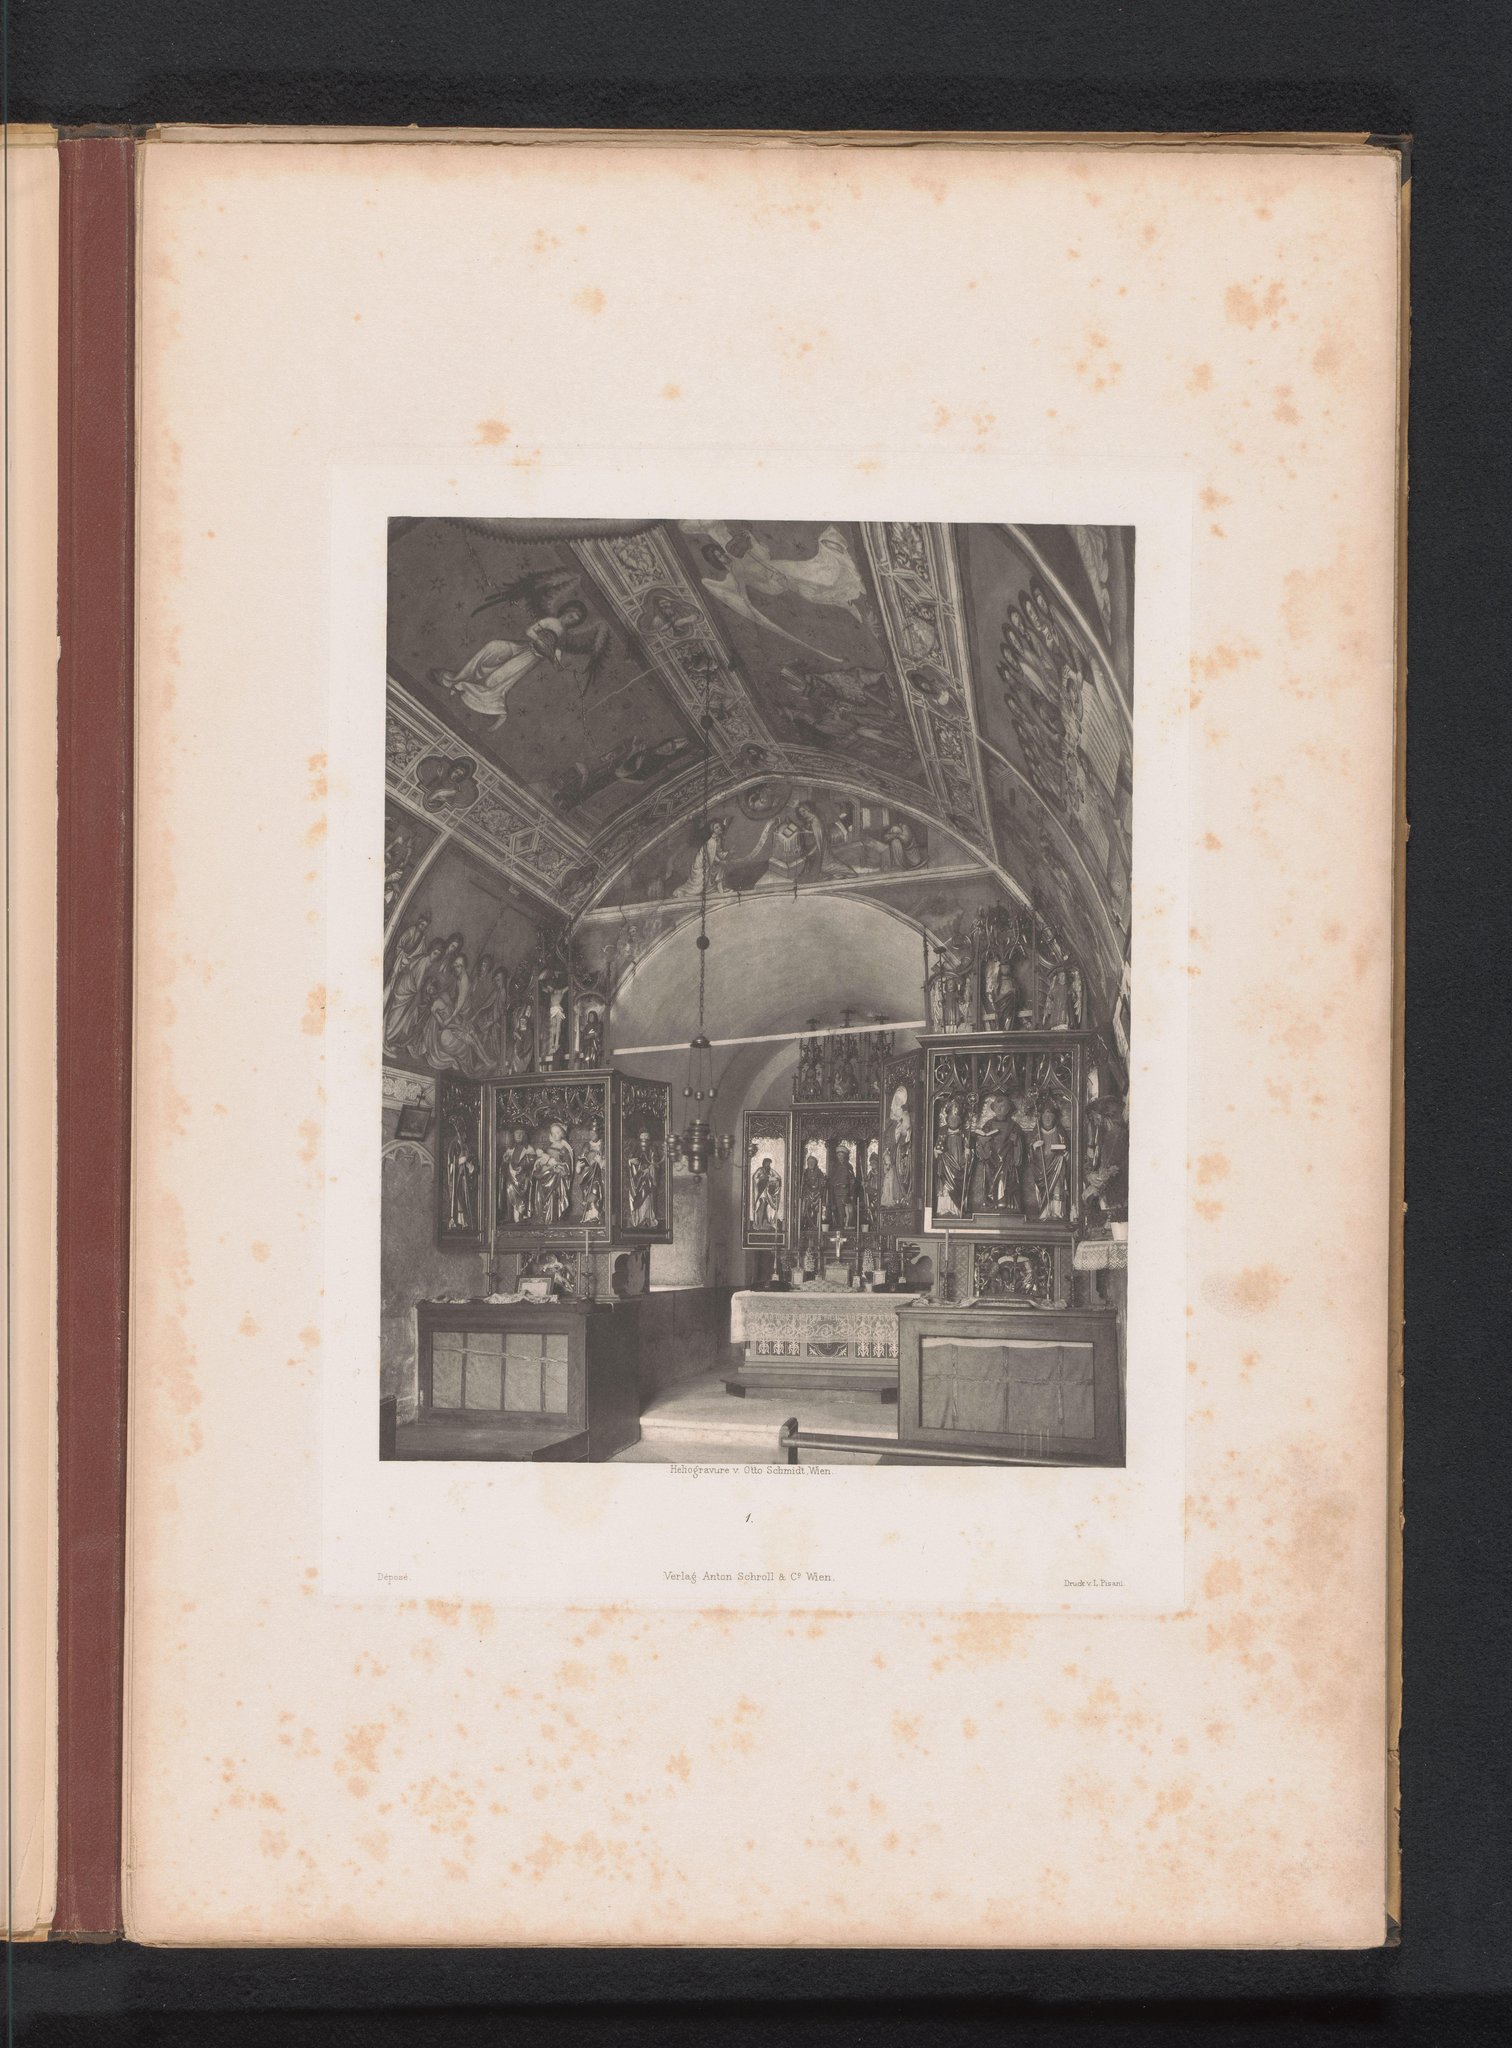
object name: photomechanical print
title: Gezicht op plafondschilderingen en schilderijen in een gebouw in de regio Lungiarü in zuid-Tirol, Italië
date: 1888-1893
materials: paper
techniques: photoaquatint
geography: vienna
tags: picture, painting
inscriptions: number: ‘1.’, inscription: ‘Déposé.’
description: Deze prent maakt deel uit van een omslag met twintig prenten, twee tekstbladen en een titelpagina.